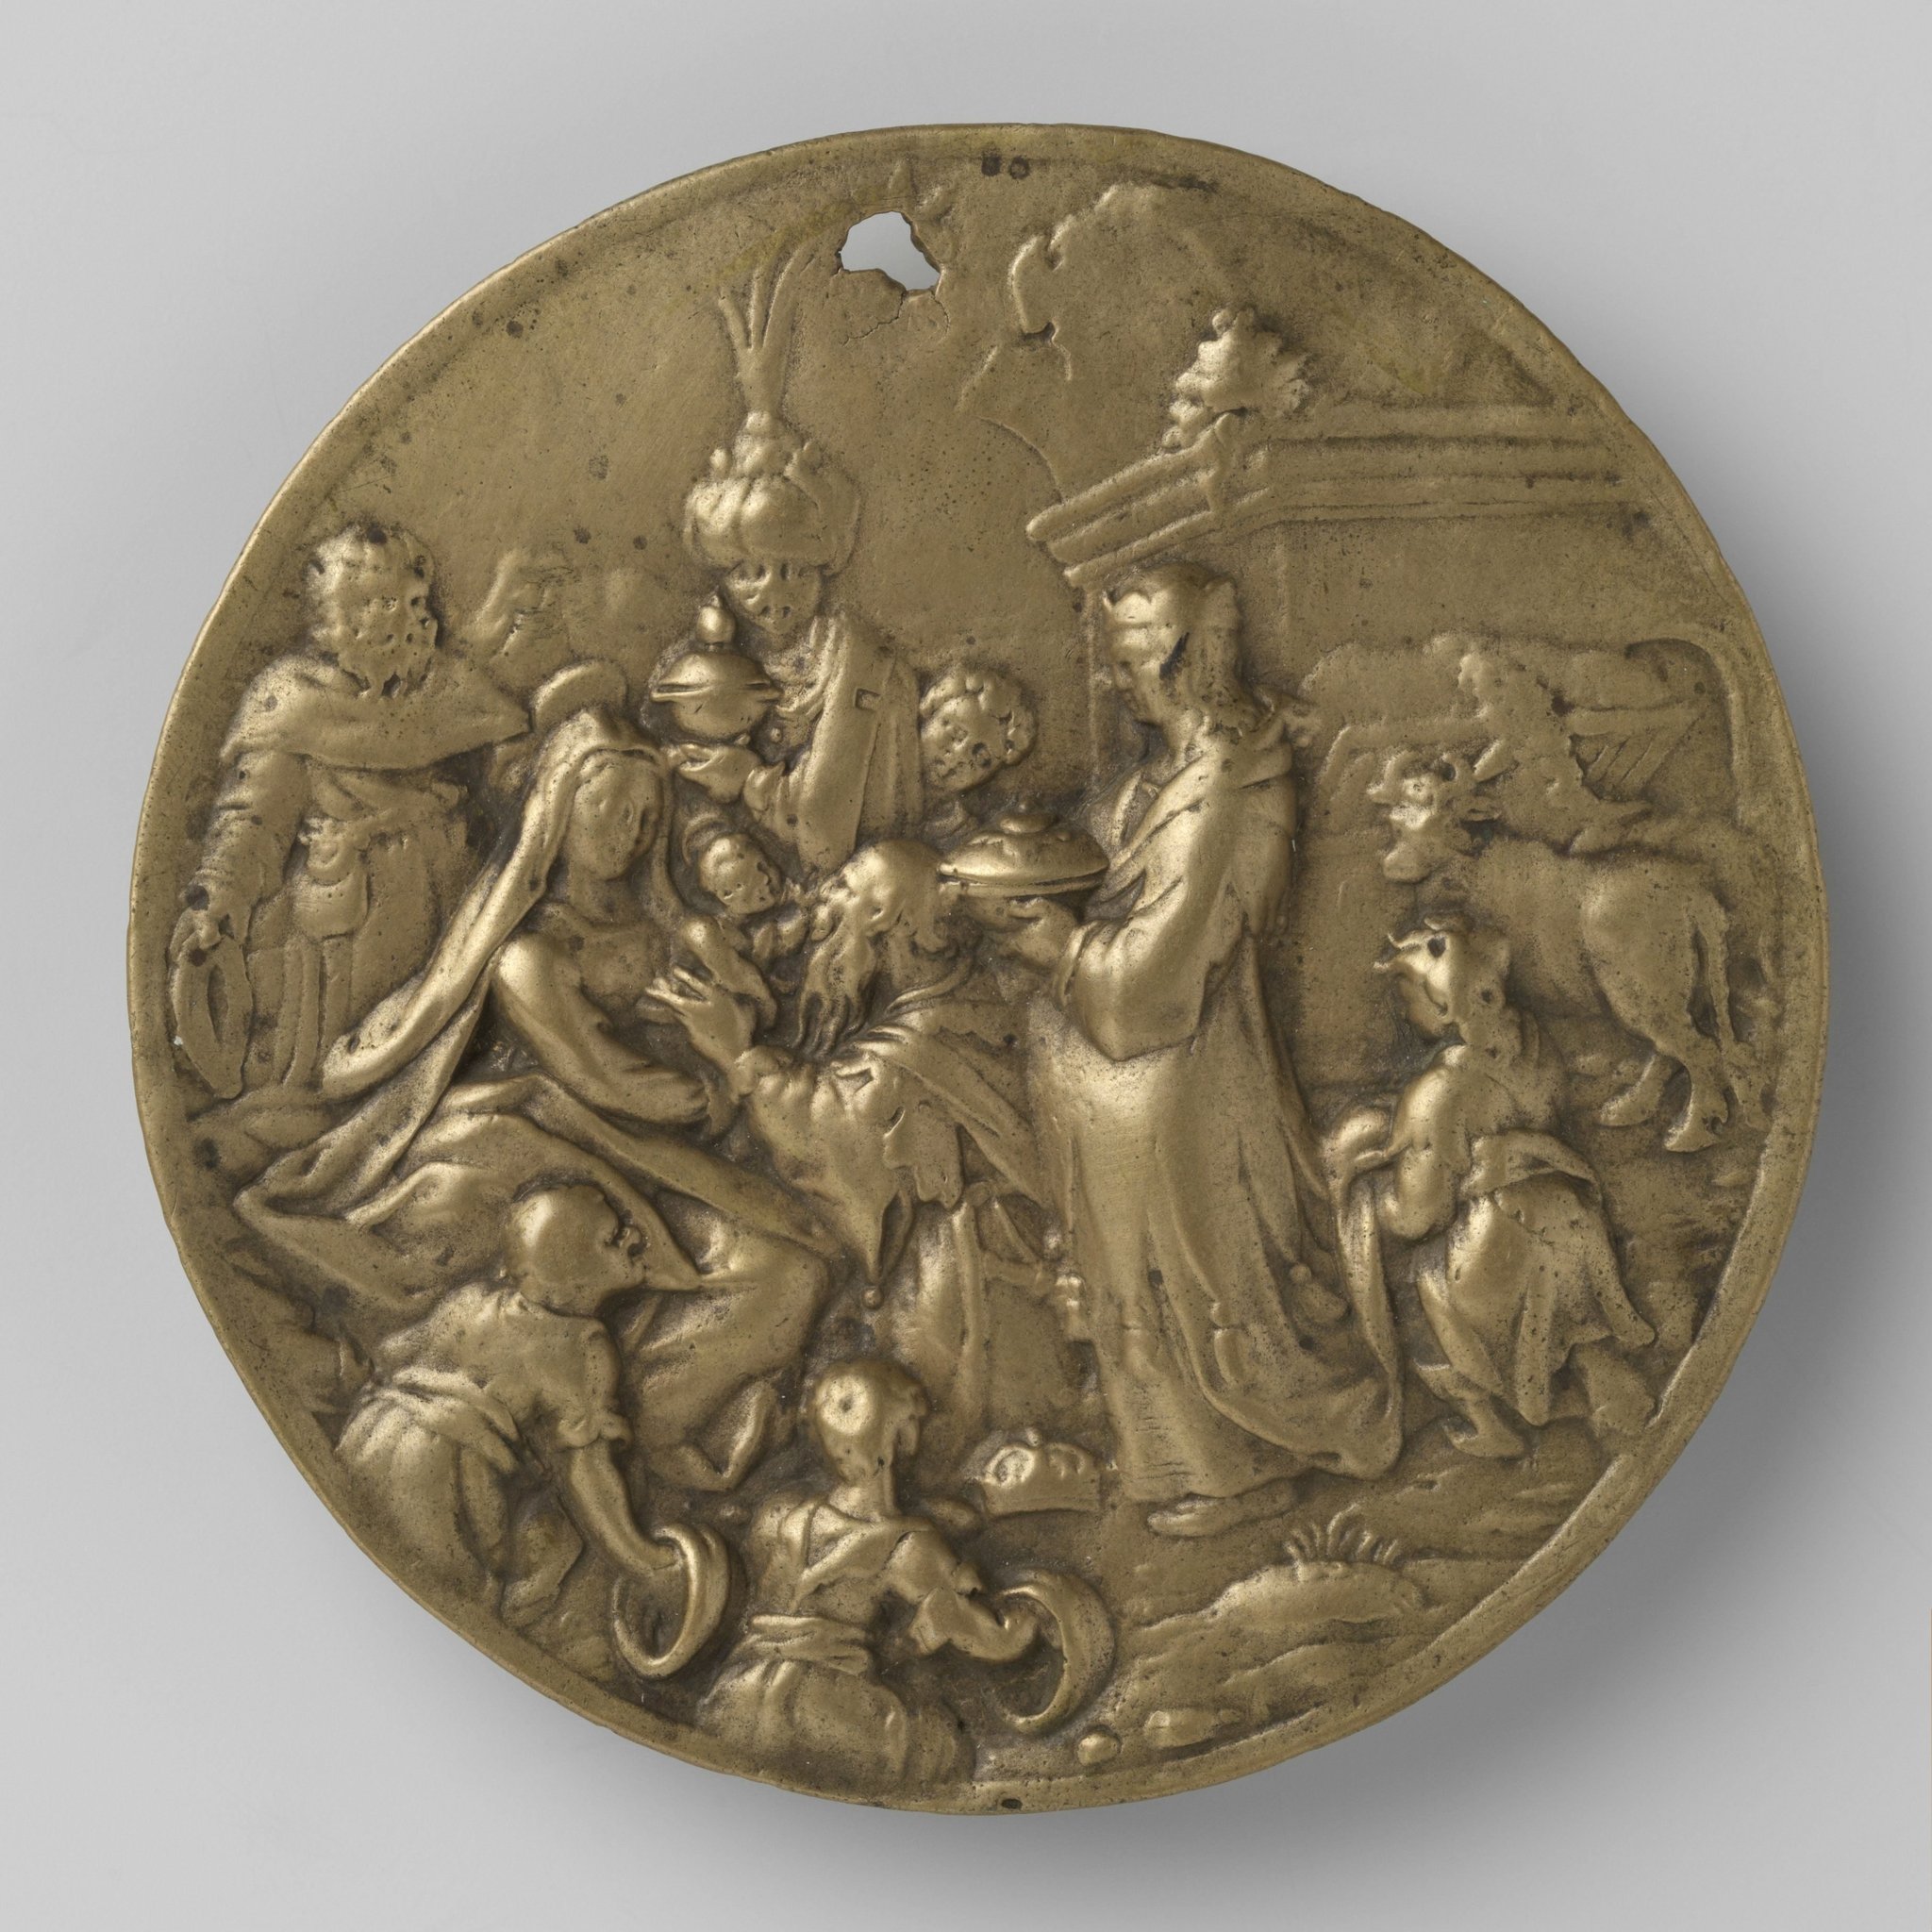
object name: plaque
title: Aanbidding der koningen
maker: Anonymous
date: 1625-1650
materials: bronze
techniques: casting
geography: netherlands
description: Ronde, bronzen plaquette. Links Maria met het Kind, Jozef en de oudste koning, die voor haar geknield ligt. Meer naar rechts de tweede en achter de groep op het tweede plan de Morenkoning. Op de voorgrond links en, iets verder naar de diepte rechts, knielende figuren van de rugzijde gezien.